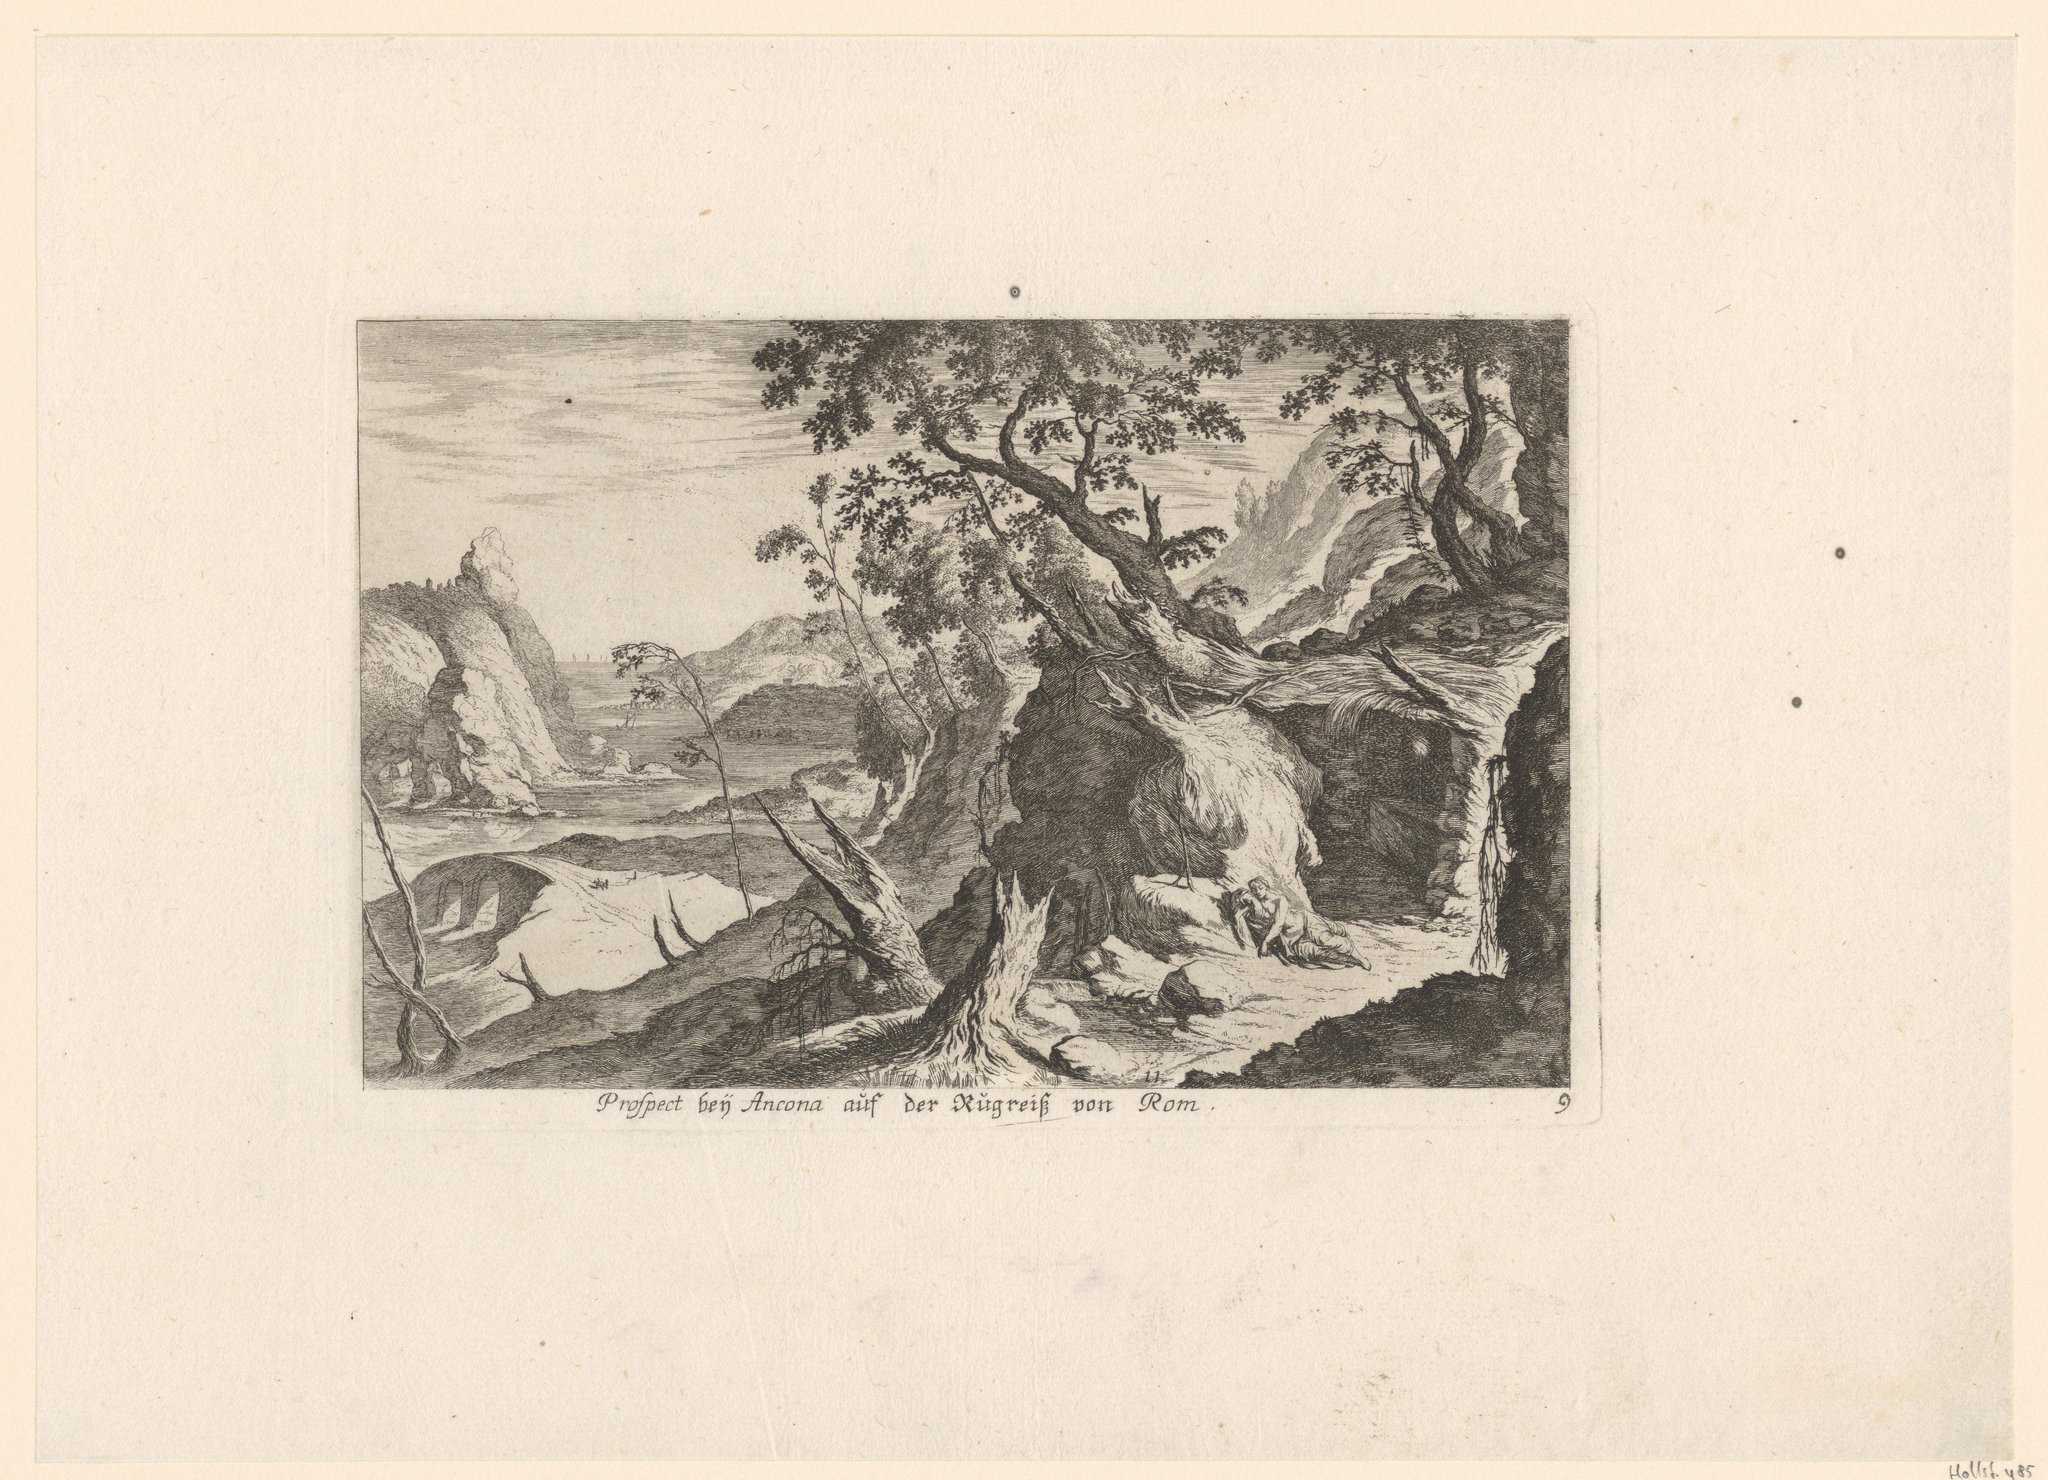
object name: print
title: Gezicht op de kust bij Ancona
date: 1670-1719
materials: paper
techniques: etching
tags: rocky coast, (traveller) resting in the open air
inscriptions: collector's mark: Lugt 2228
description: Deze prent is deel van de serie: Schöne und Wahre Landschafften in Italien und andern Landern. Augsburg: Johann Ulrich Kraus, 1675-1685. De serie bestaat uit veertien prenten plus een titelprent. Deze uitgave omvat een selectie van de 146 prenten uit de uitgave getiteld 'Joannis Guilielmi Baurn Iconographia completens in se, Passionem (...) Per Italiam, Spectatu Sunt', voor het eerst uitgegeven in Augsburg in 1670.